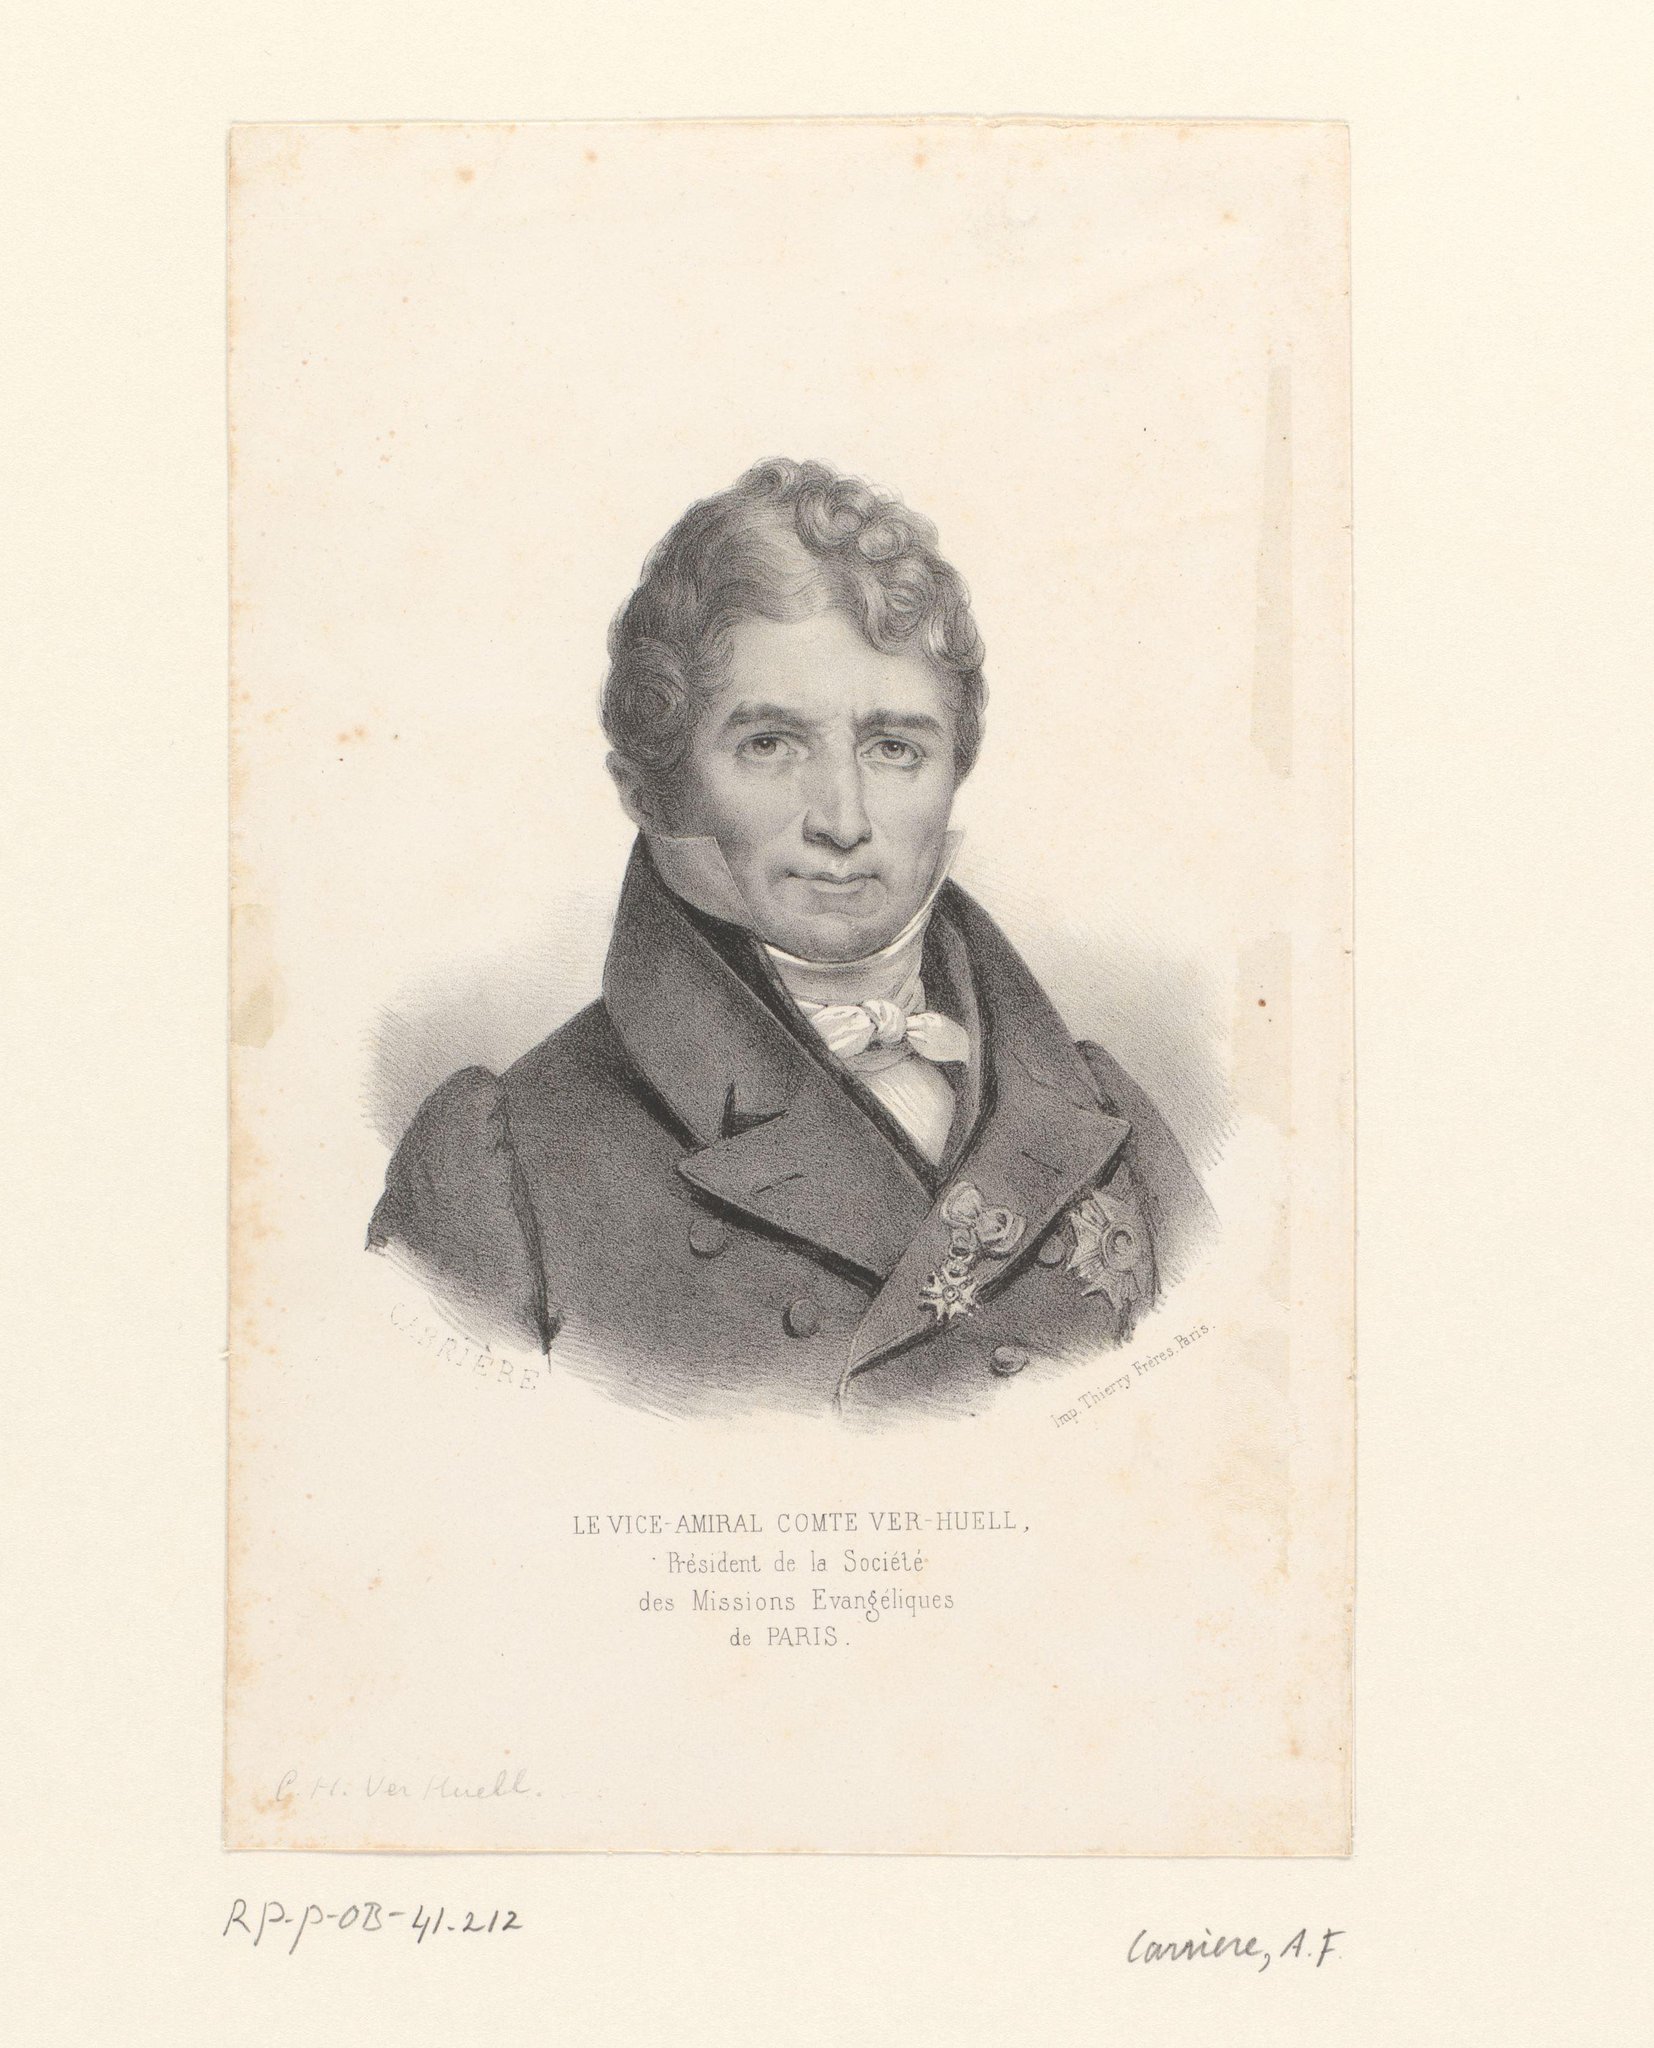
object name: print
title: Le Vice-Amiral Comte Ver-Huell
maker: antoine fulcrand carrière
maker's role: print maker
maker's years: 1804-1856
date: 1830-1855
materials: paper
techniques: lithograph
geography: paris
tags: paris, historical persons